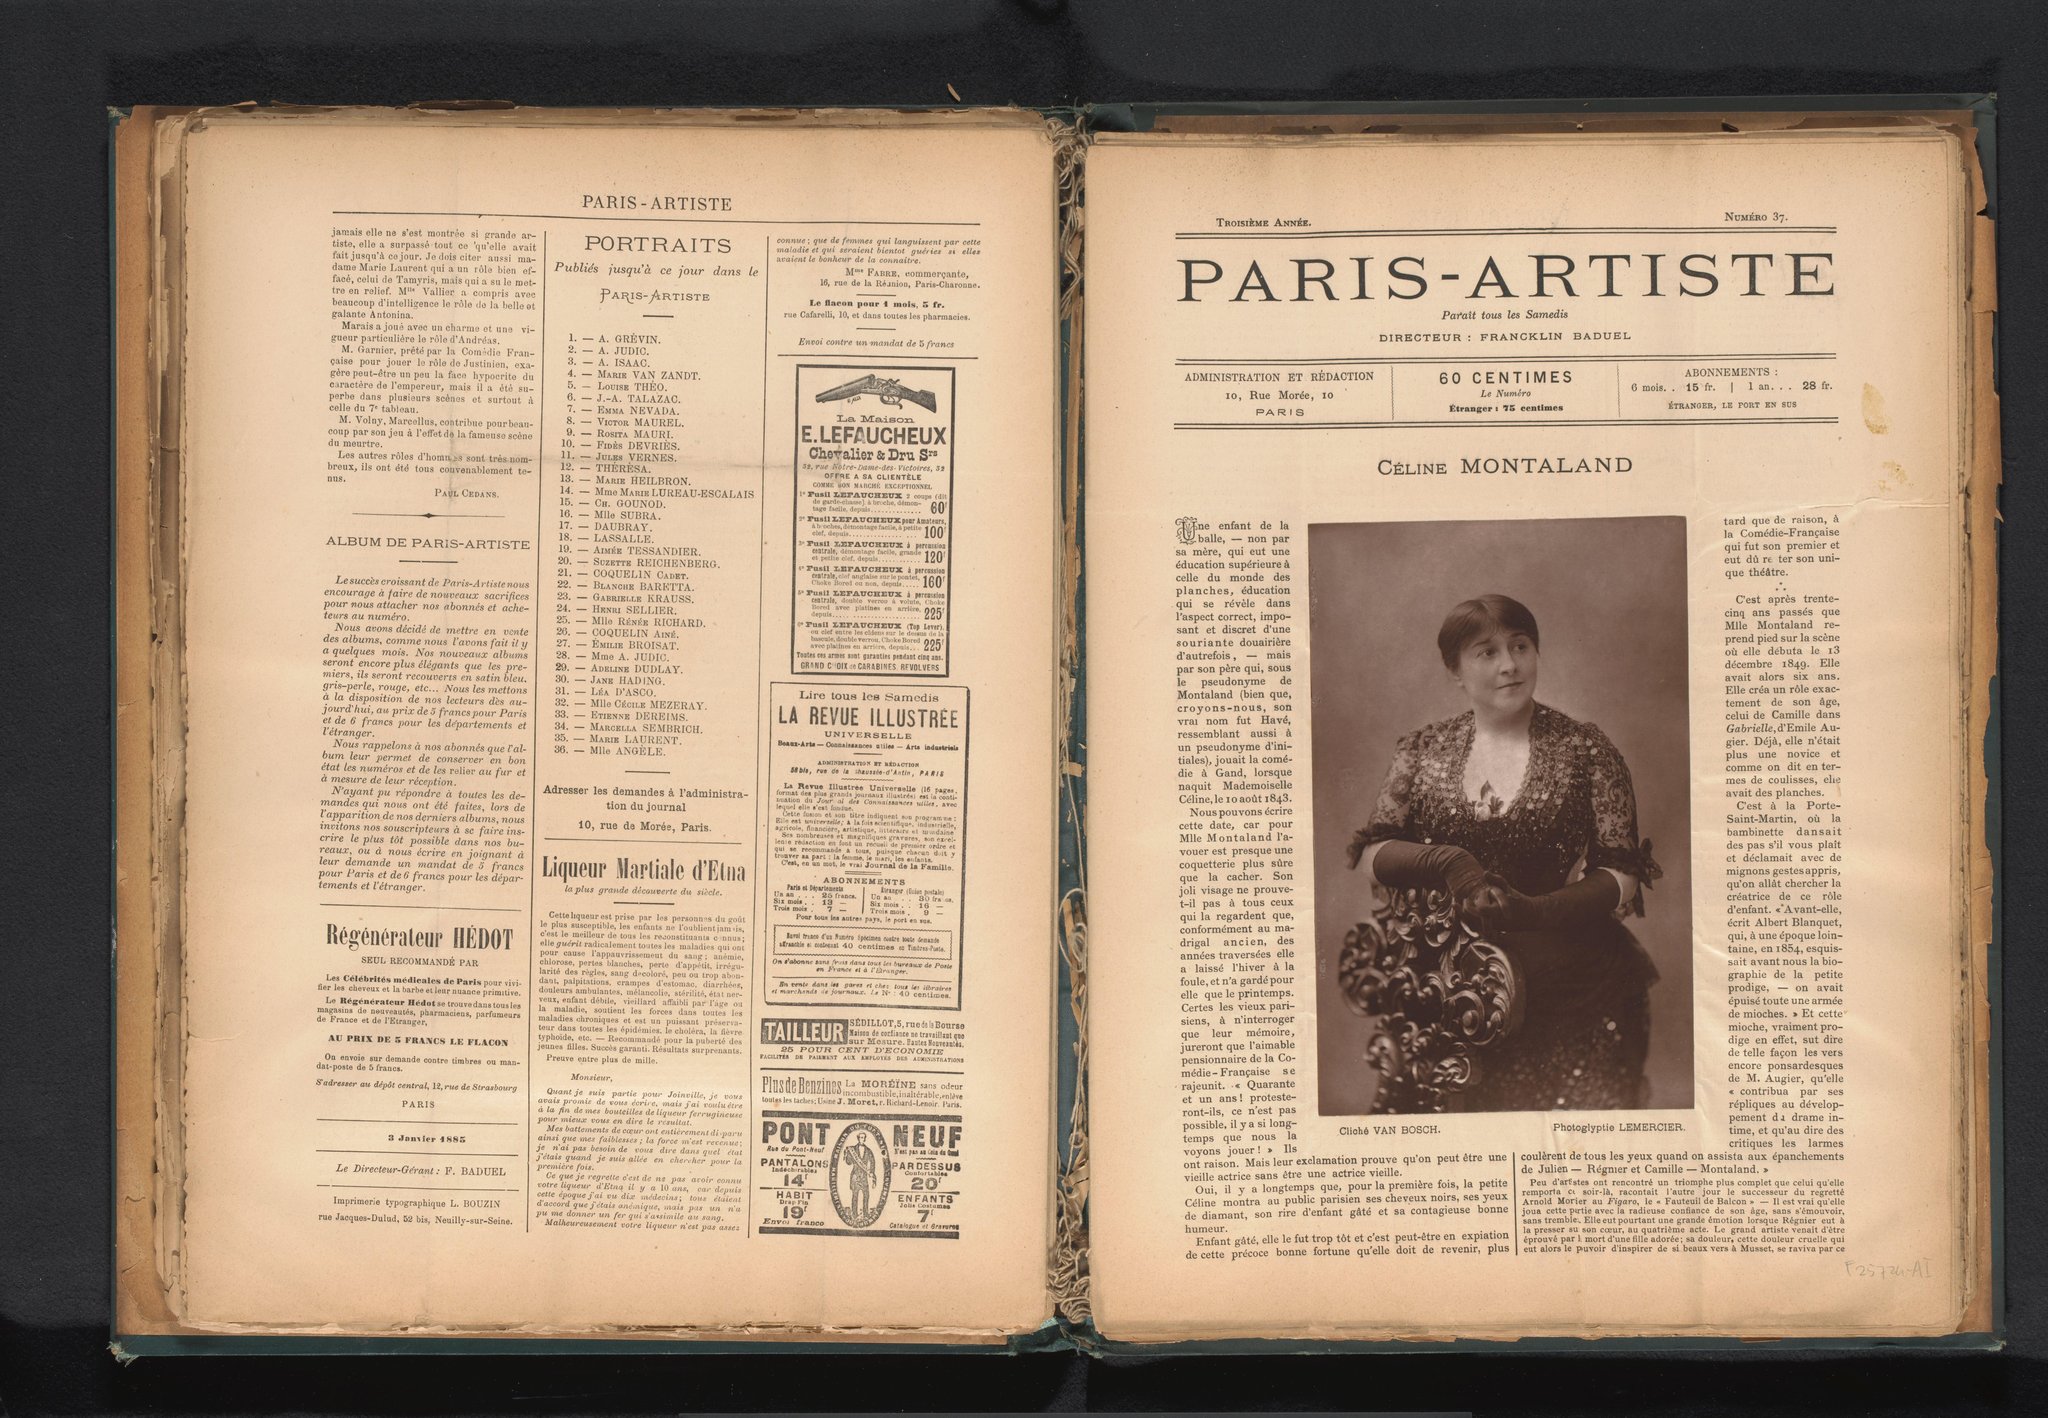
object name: page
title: Portret van Céline Montaland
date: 1880-1885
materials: paper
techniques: woodburytype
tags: historical persons - bb - woman, portrait of actor, actress